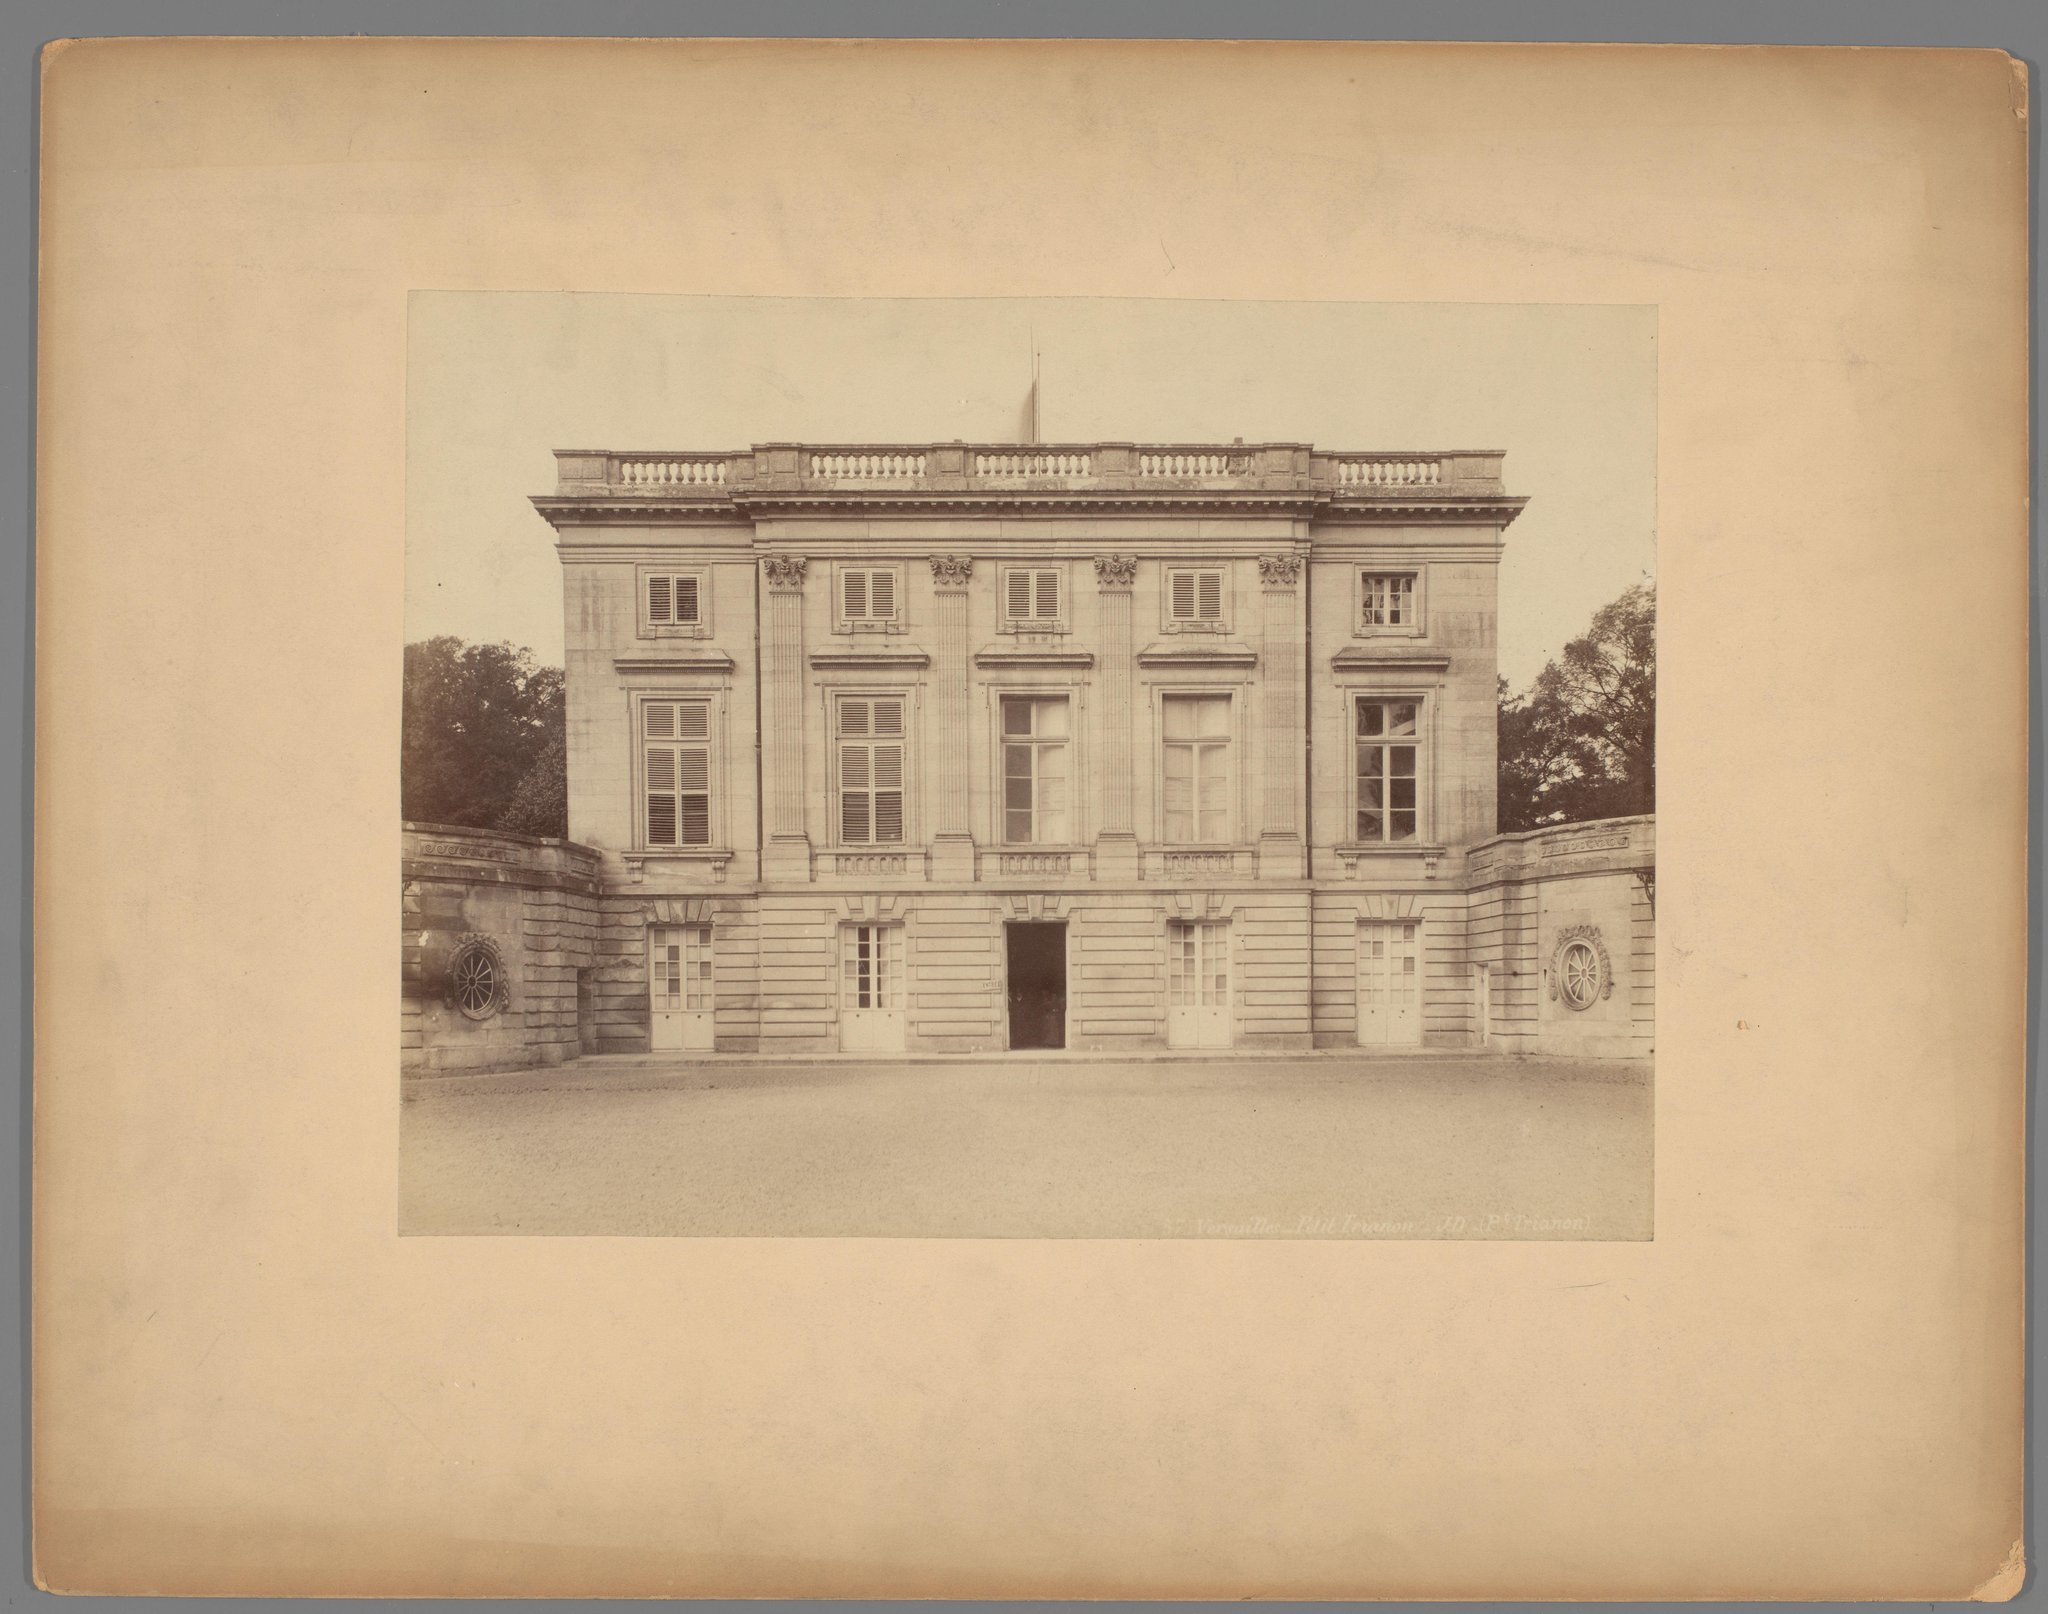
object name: photograph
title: Gezicht op Klein Trianon te Versailles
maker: Anonymous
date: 1850-1900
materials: cardboard, photographic support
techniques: albumen print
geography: versailles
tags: garden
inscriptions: number: ‘57’, collector's mark: Lugt 3937, inscription: ‘J.D. (Pt Trianon)’